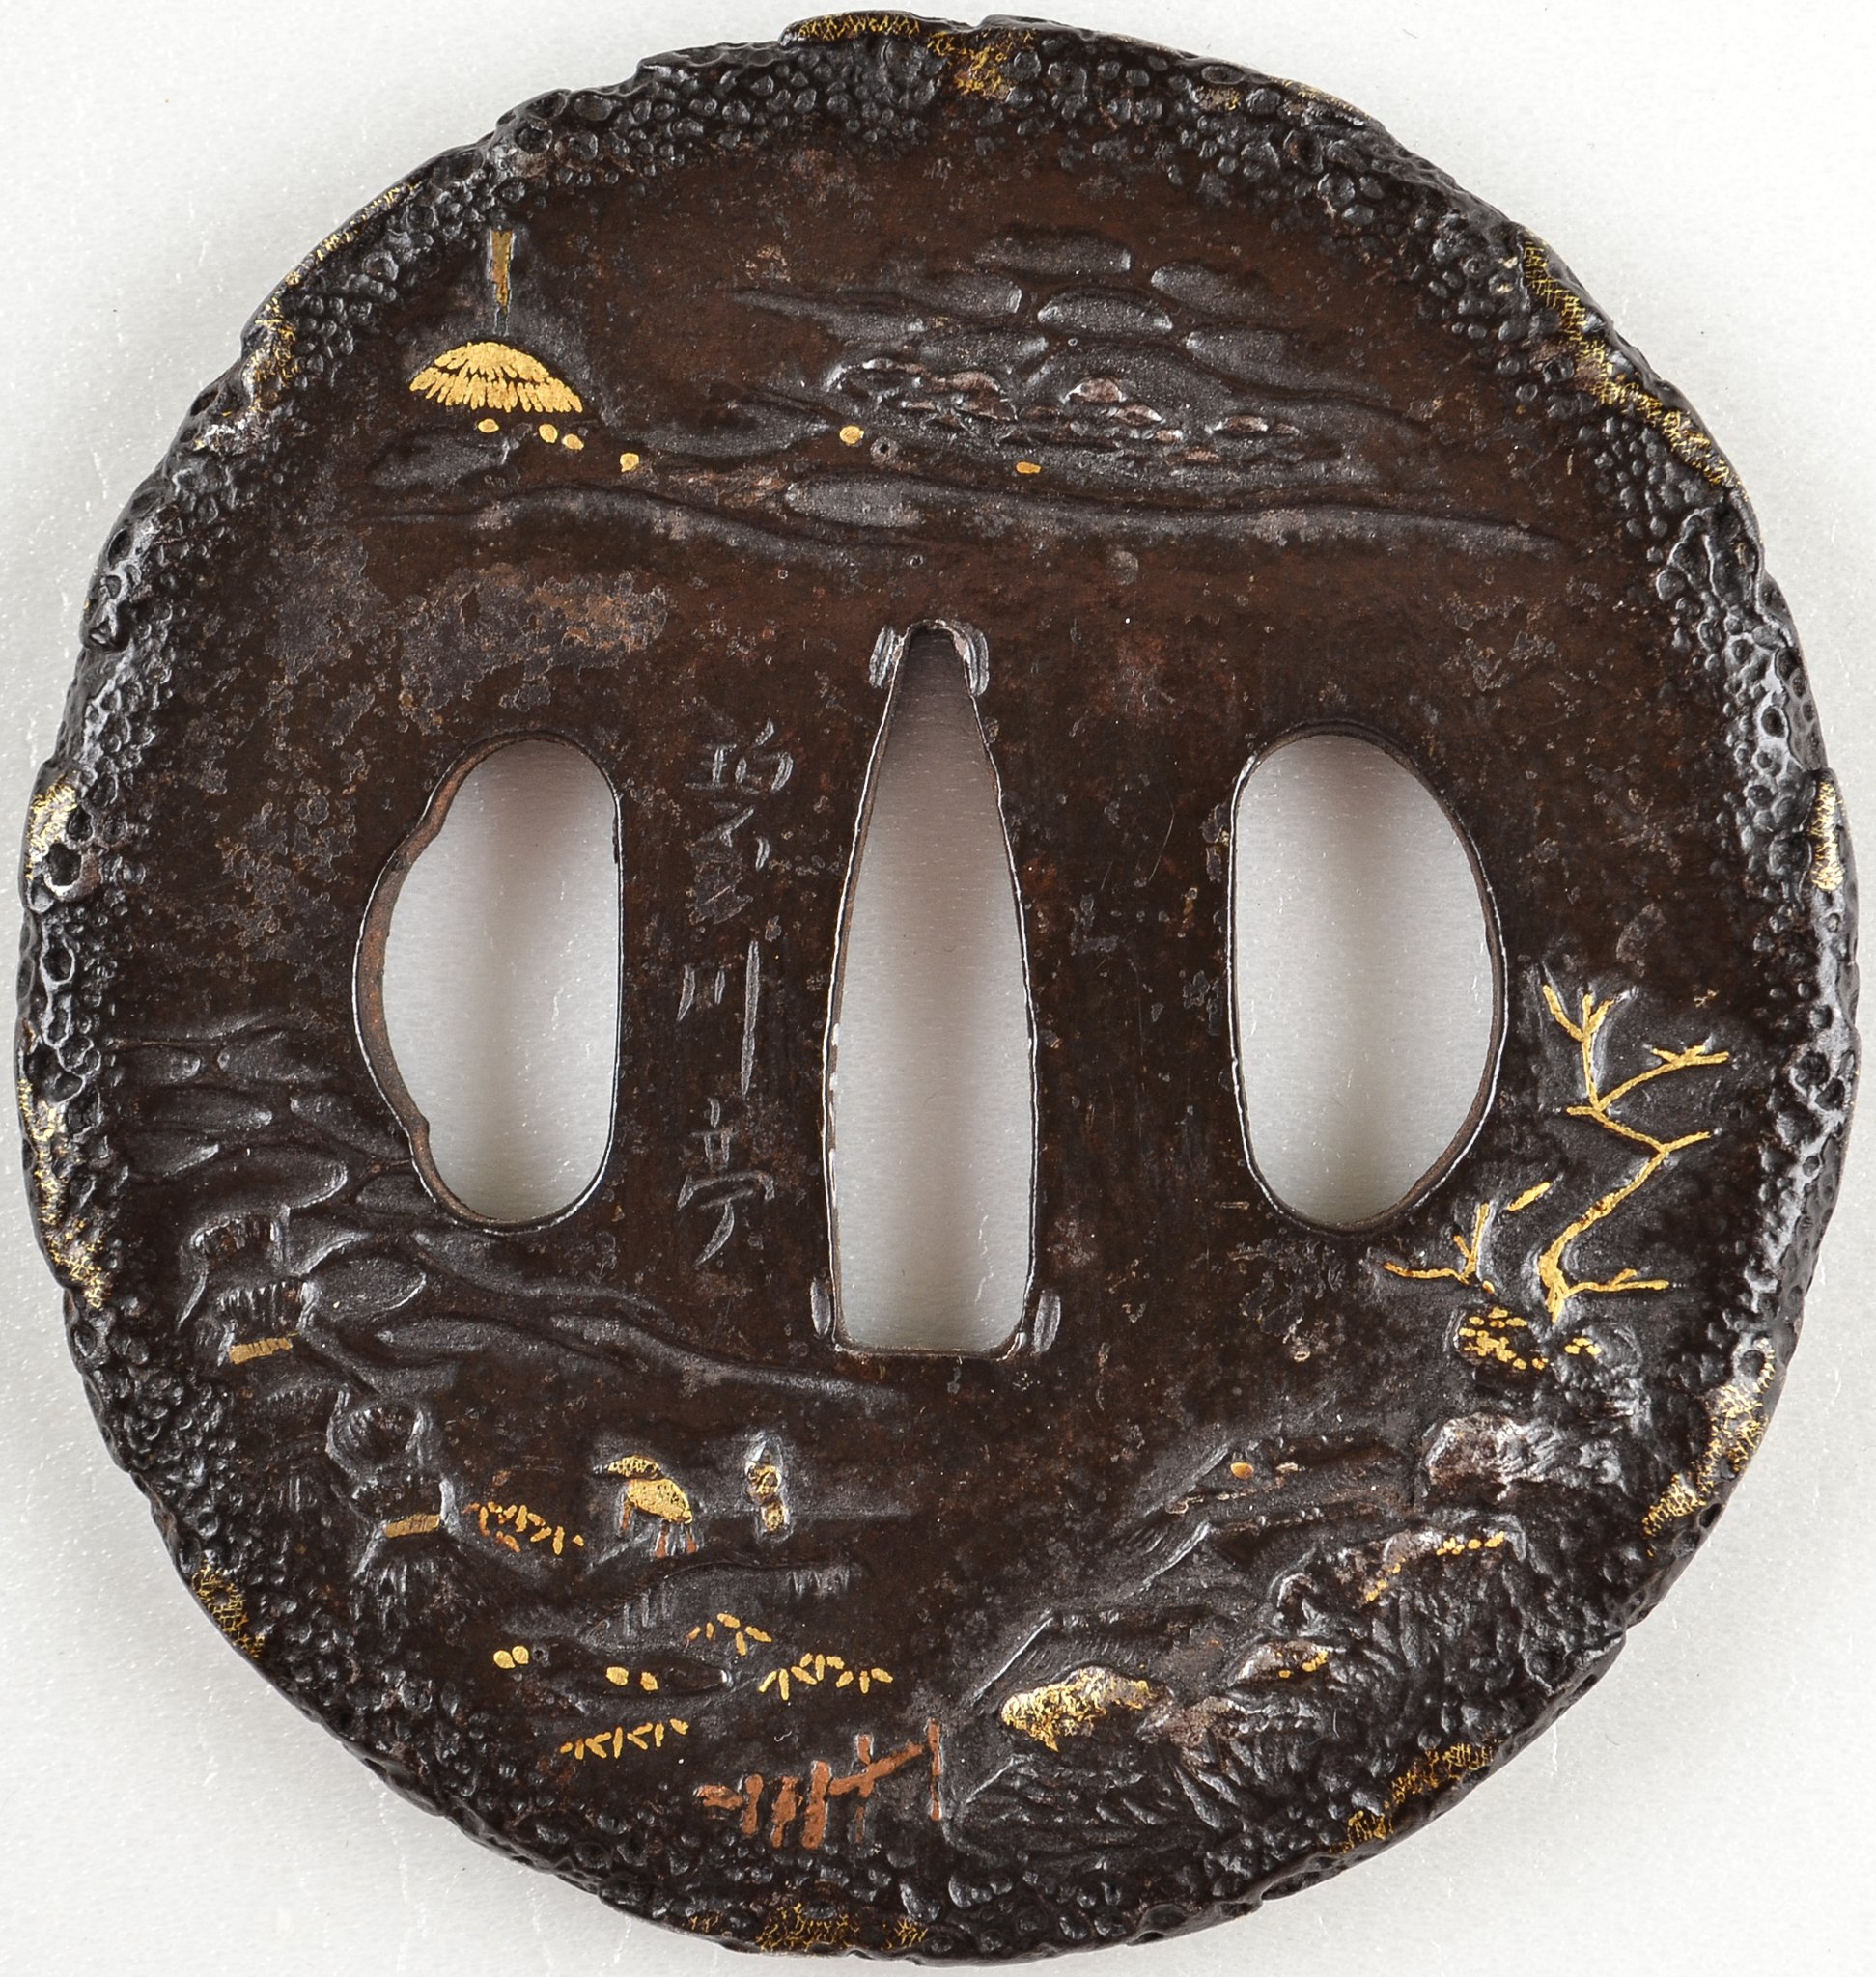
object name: sword guard tsuba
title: Sword Guard (Tsuba) with Sansui Nanga (Mountain and Seascape) Design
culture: japanese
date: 1701-1800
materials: gold, iron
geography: japan